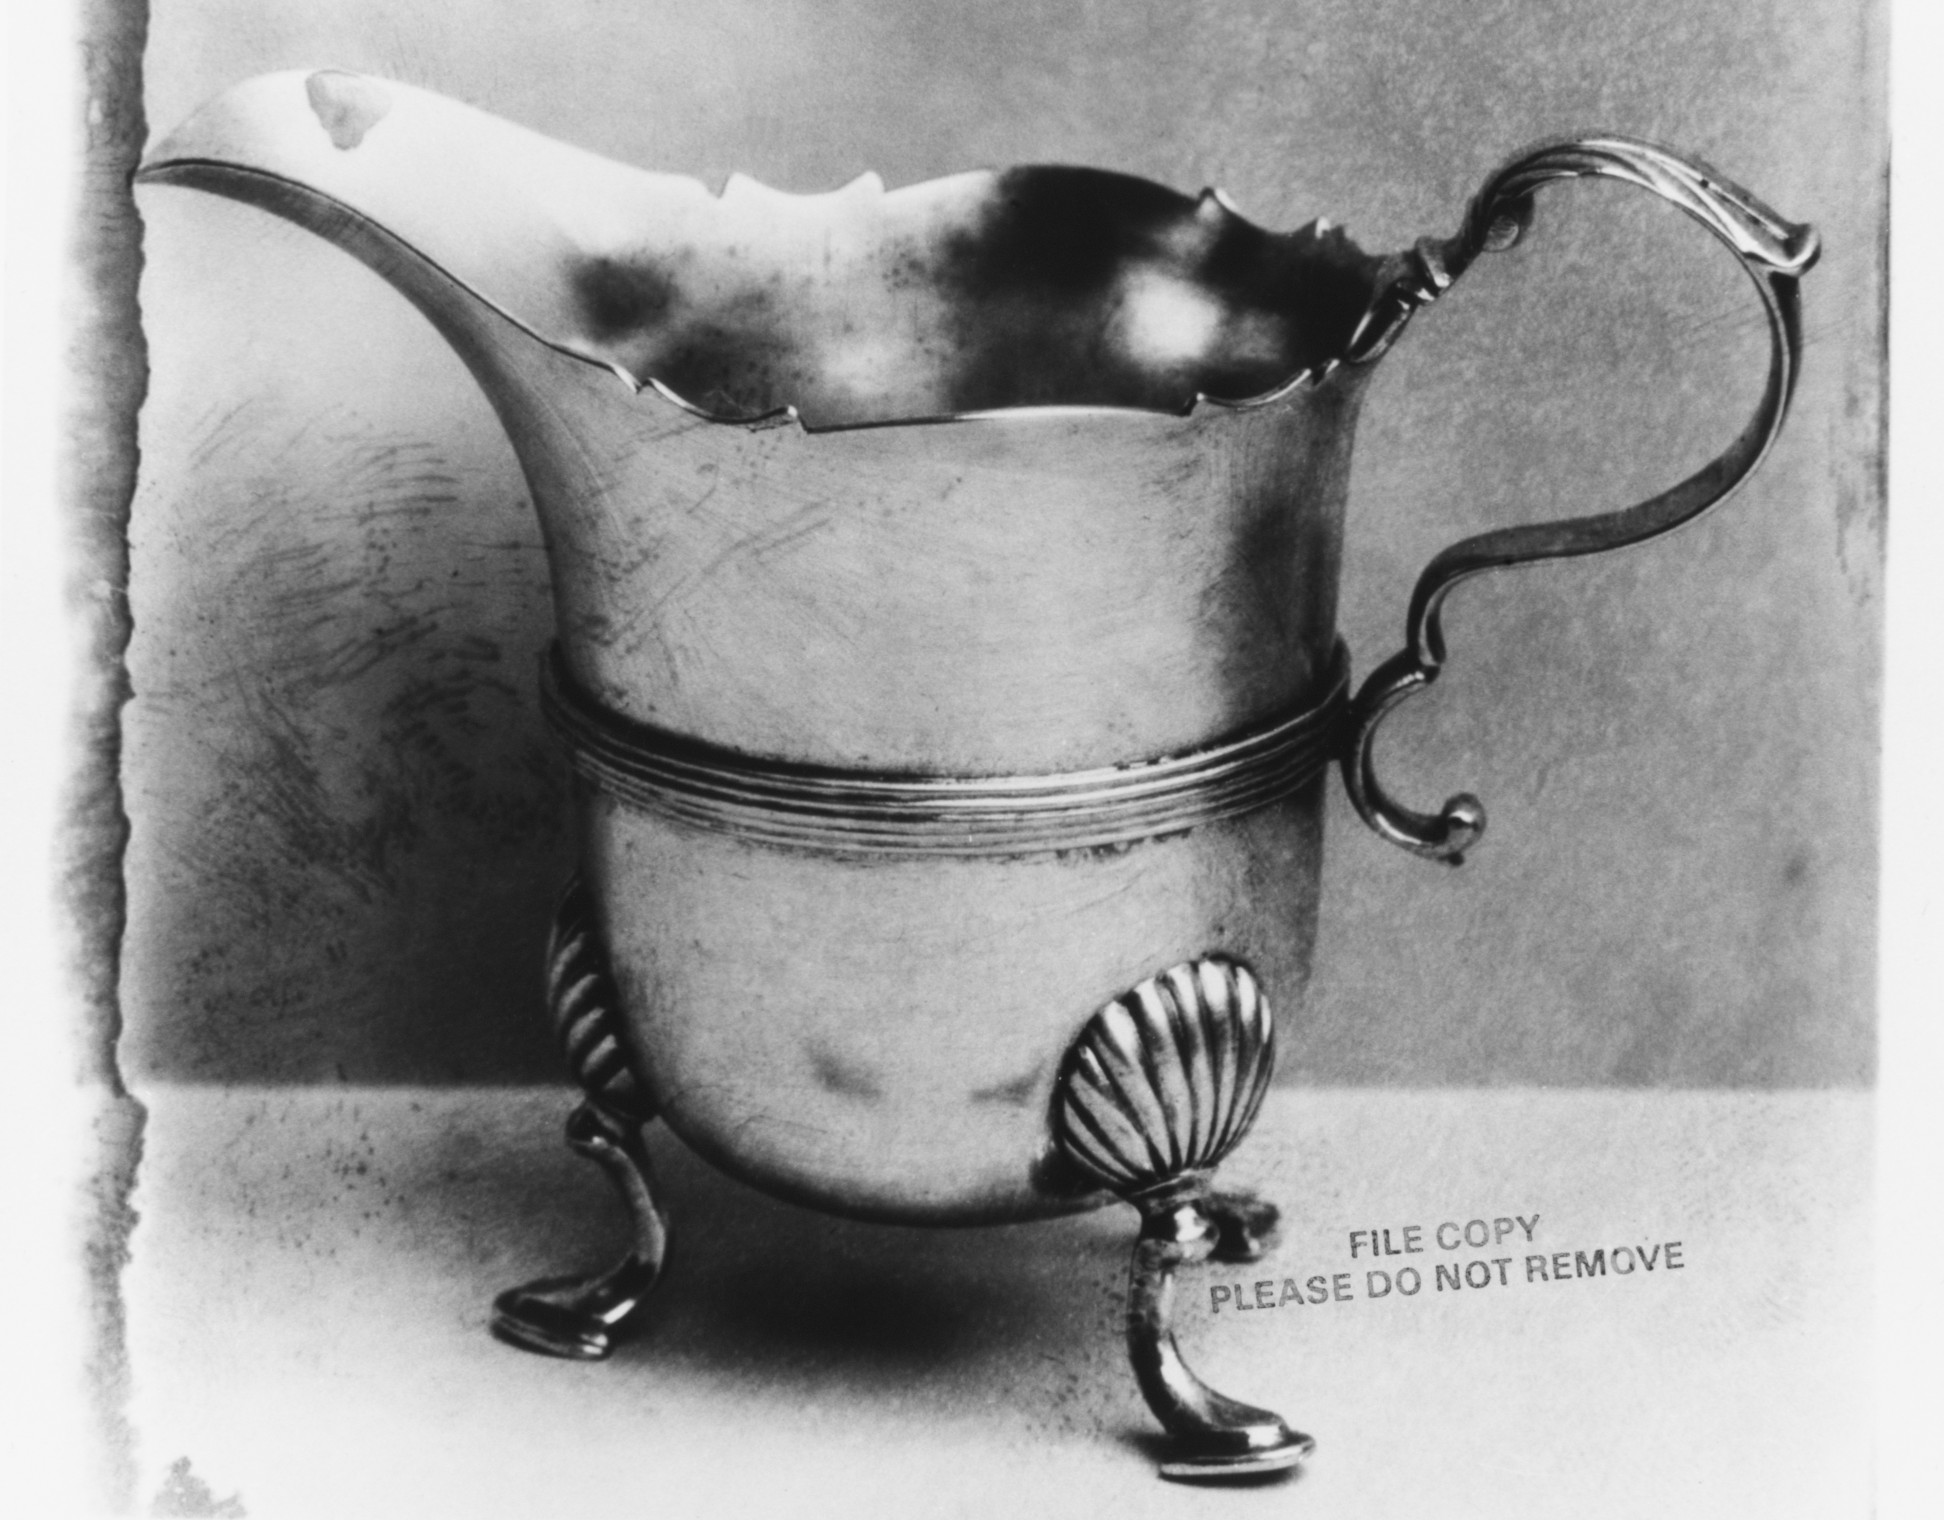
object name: cream jug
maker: michael mcdermott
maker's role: maker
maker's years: 1750-1784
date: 1770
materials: silver